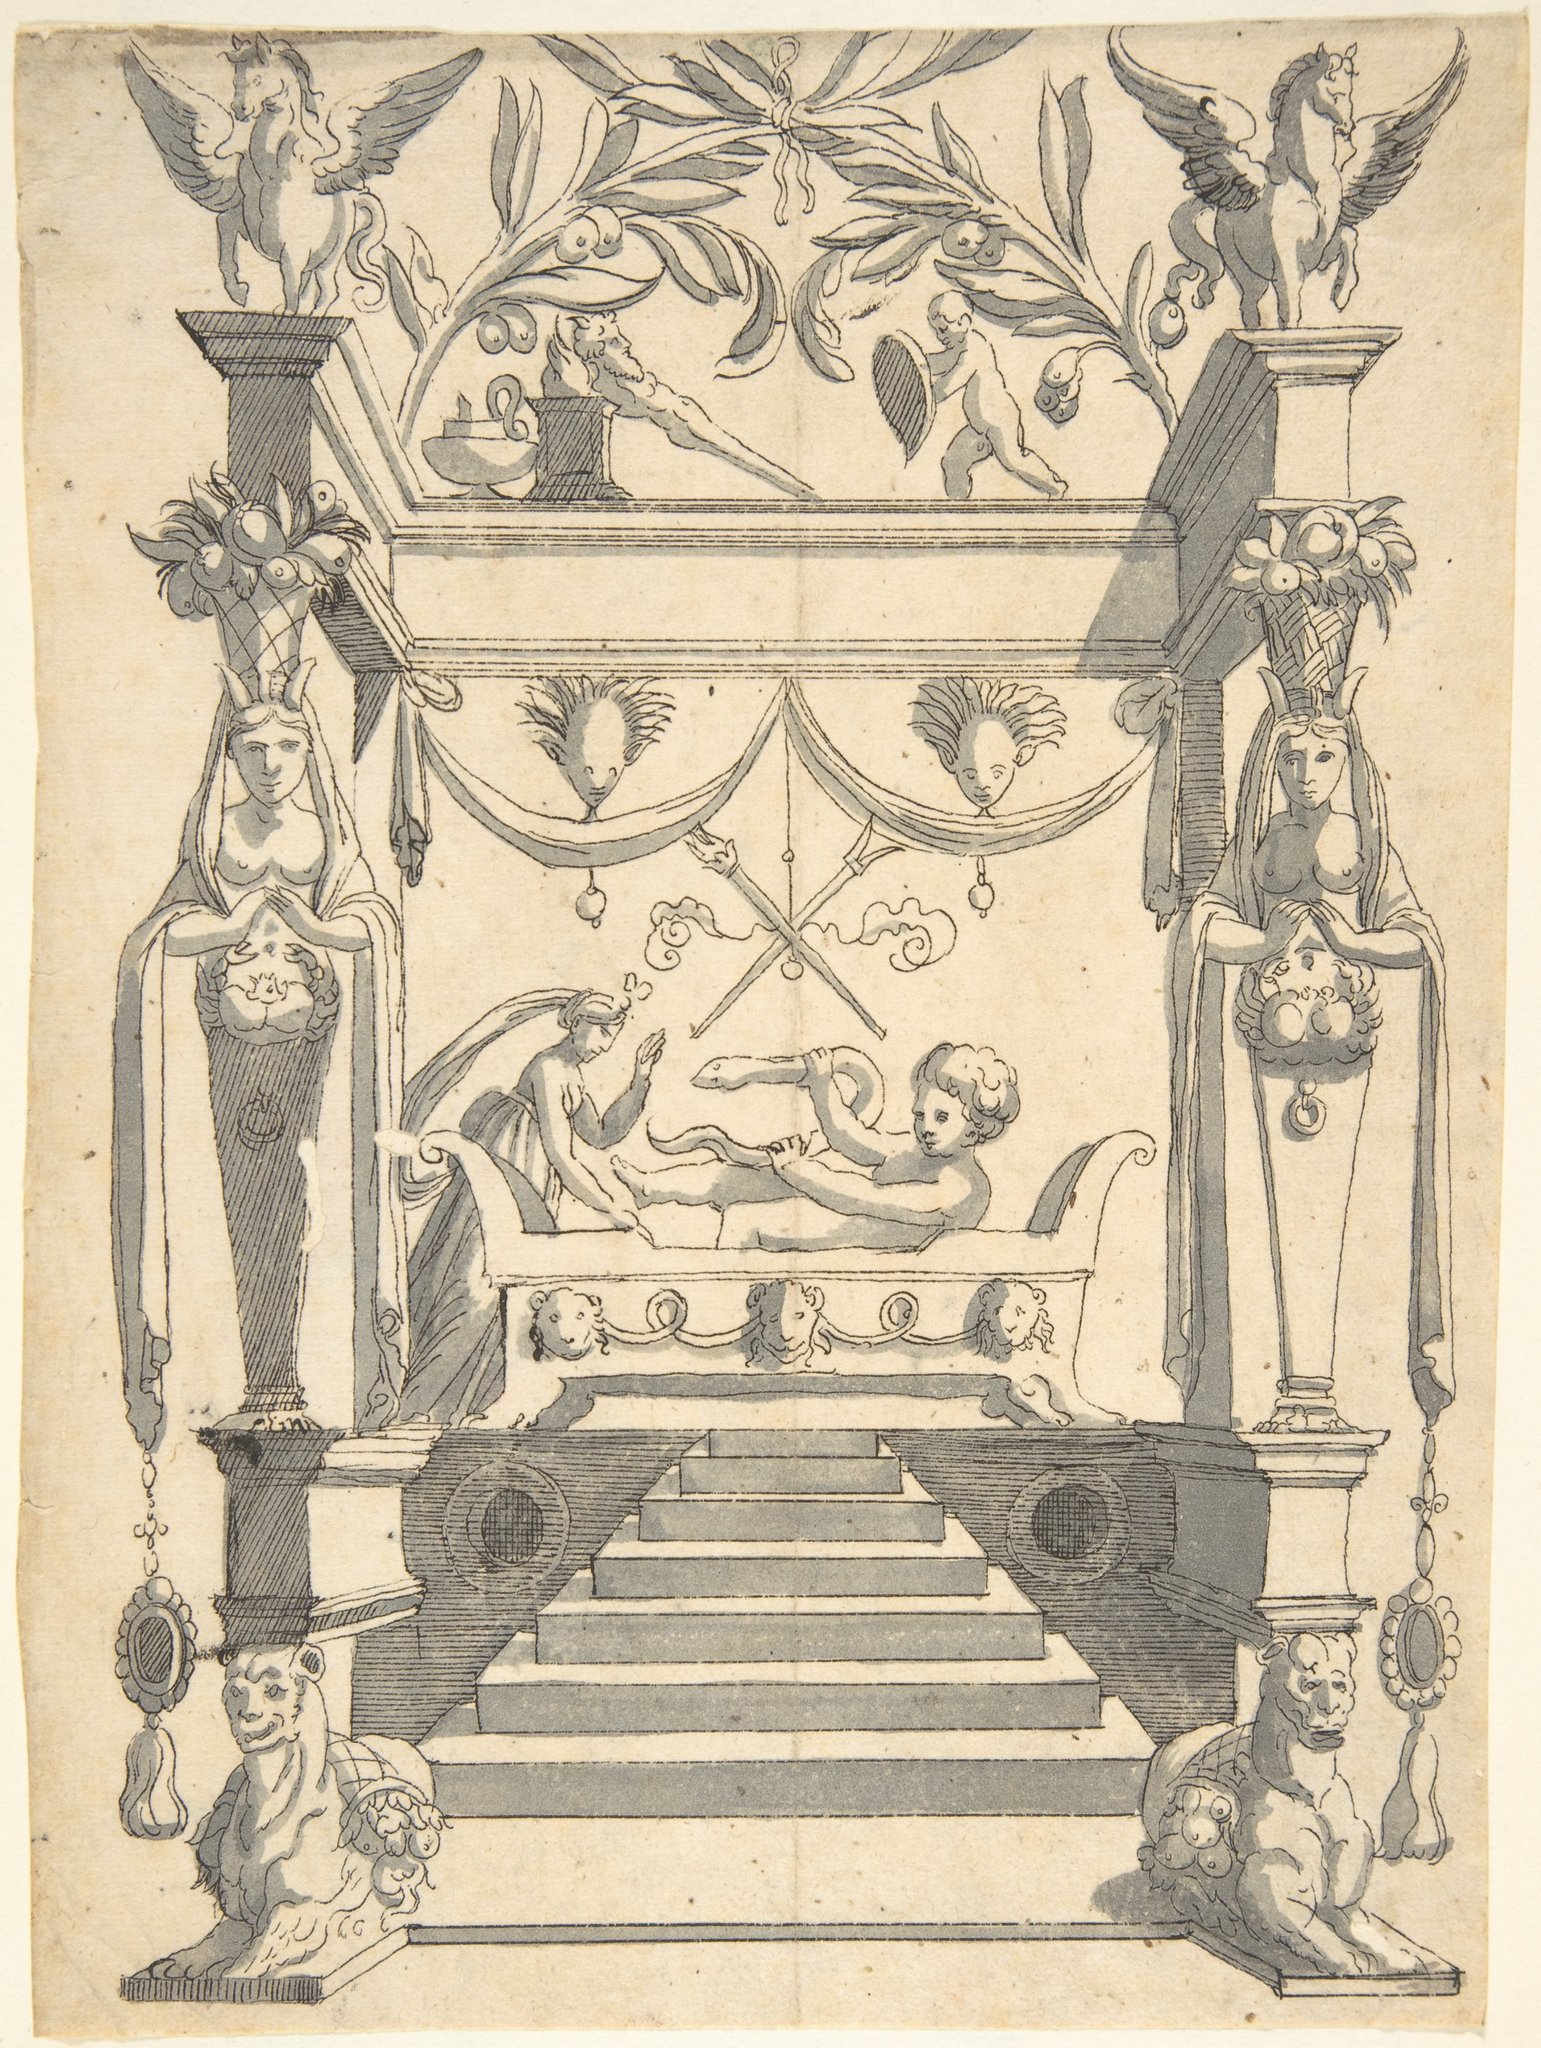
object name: ornament architecture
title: Grotesque with an Architectural Structure with a Young Boy on a Bed, Holding a Snake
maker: anonymous, italian, 16th century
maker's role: artist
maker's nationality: italian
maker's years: 1500-1600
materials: ink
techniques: brush, pen, wash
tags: grotesques,ornament,boys,mythical creatures,snakes